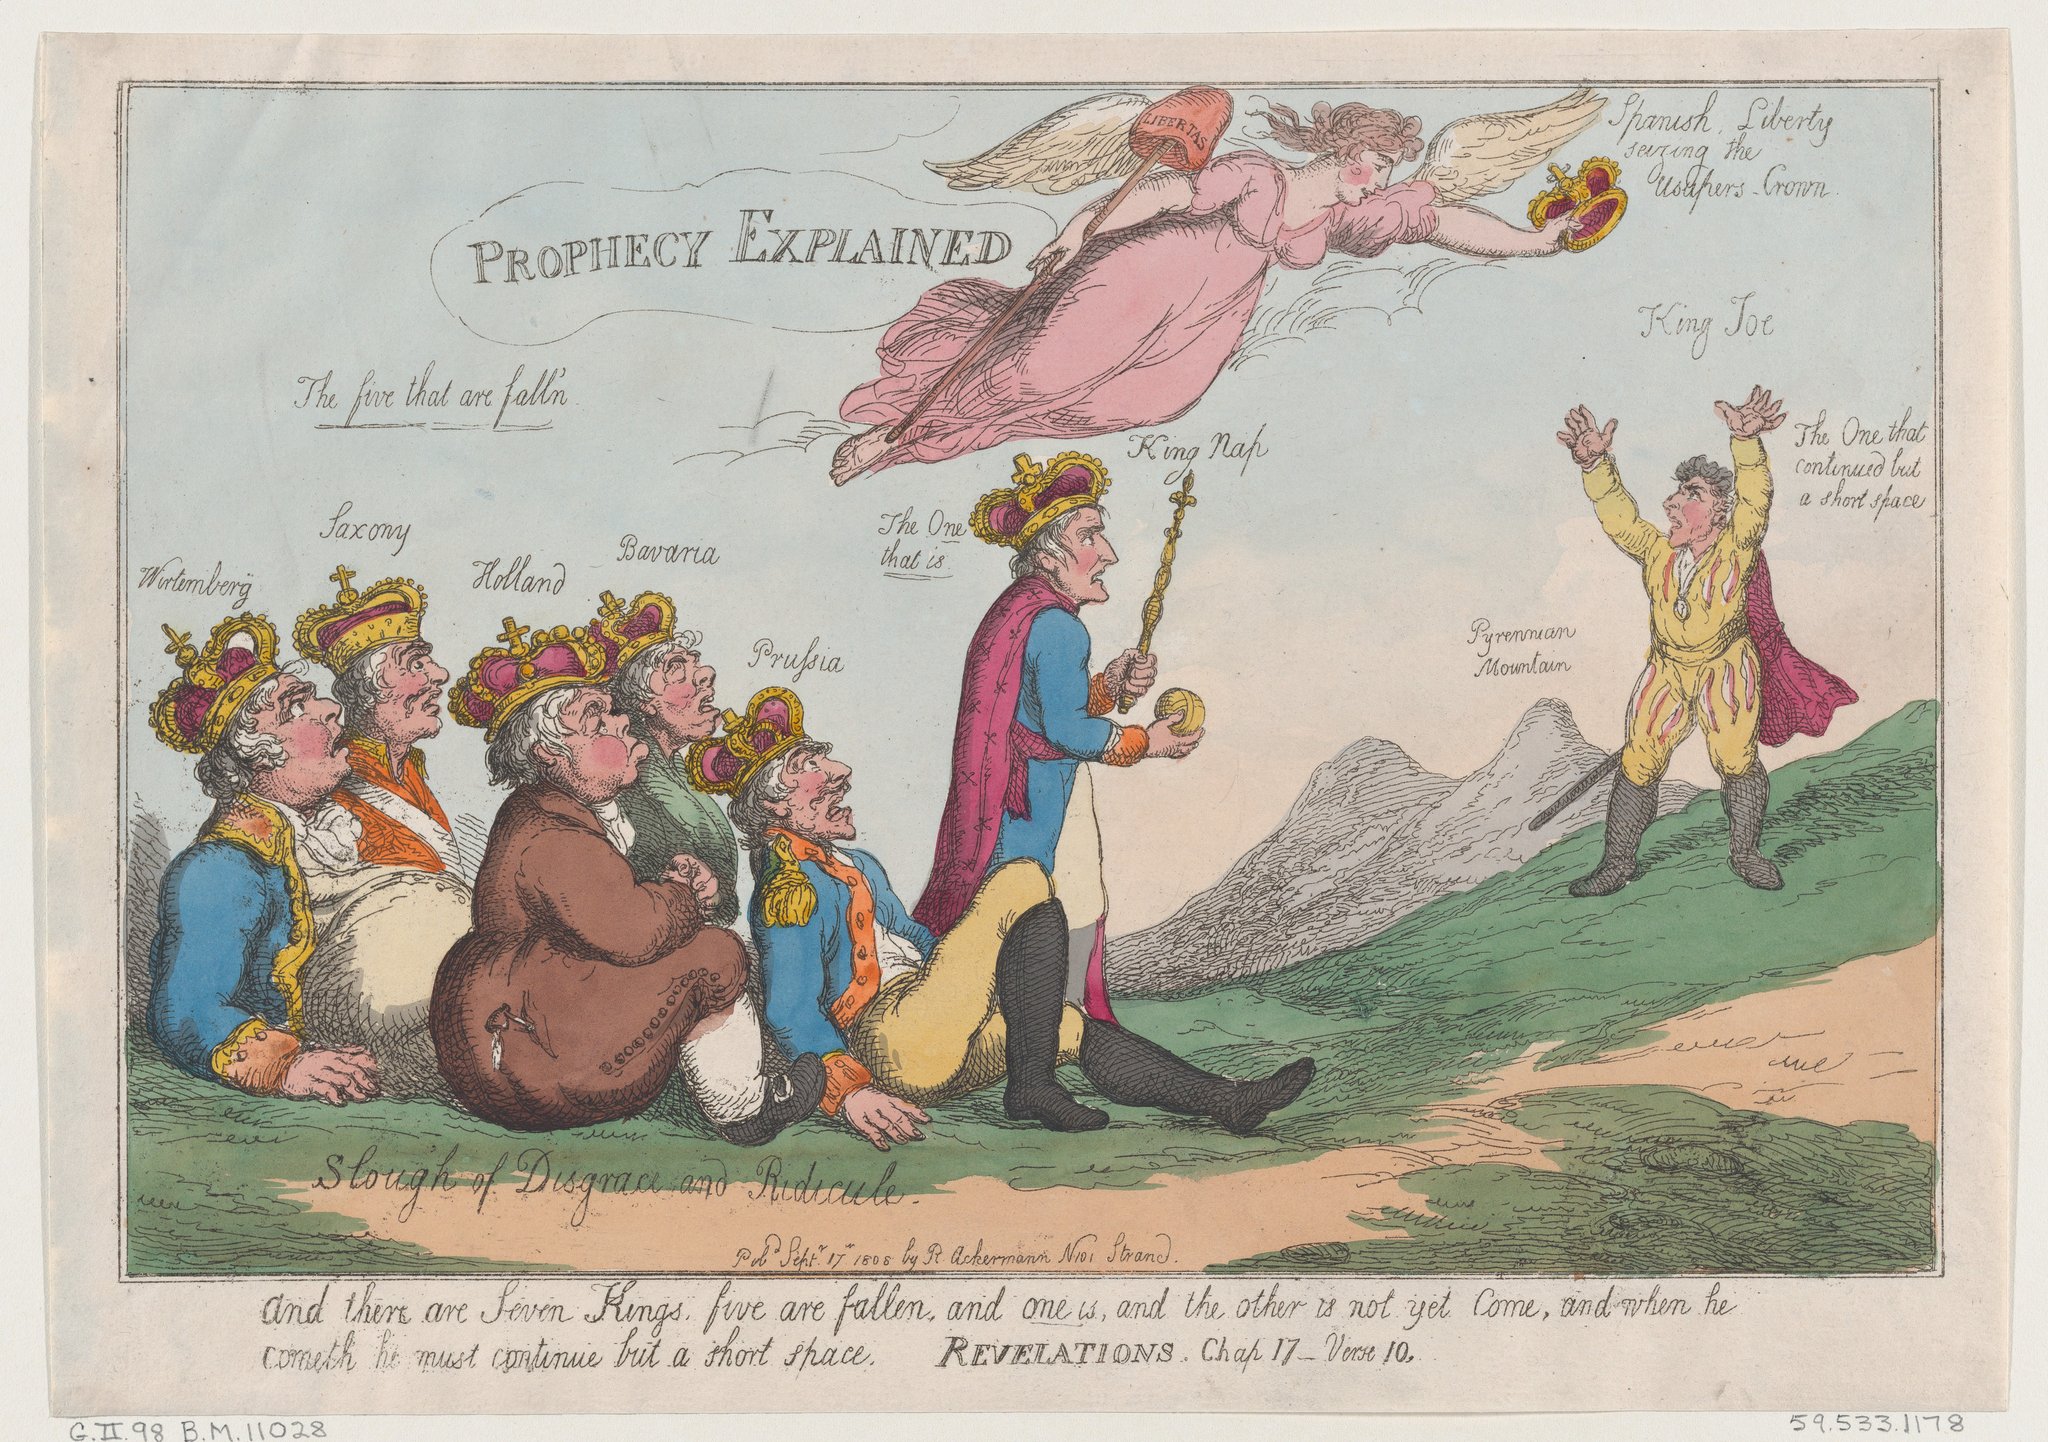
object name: print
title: Prophecy Explained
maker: thomas rowlandson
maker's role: artist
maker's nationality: british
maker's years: 1757-1827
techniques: etching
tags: satire,napoleon i,men,politics